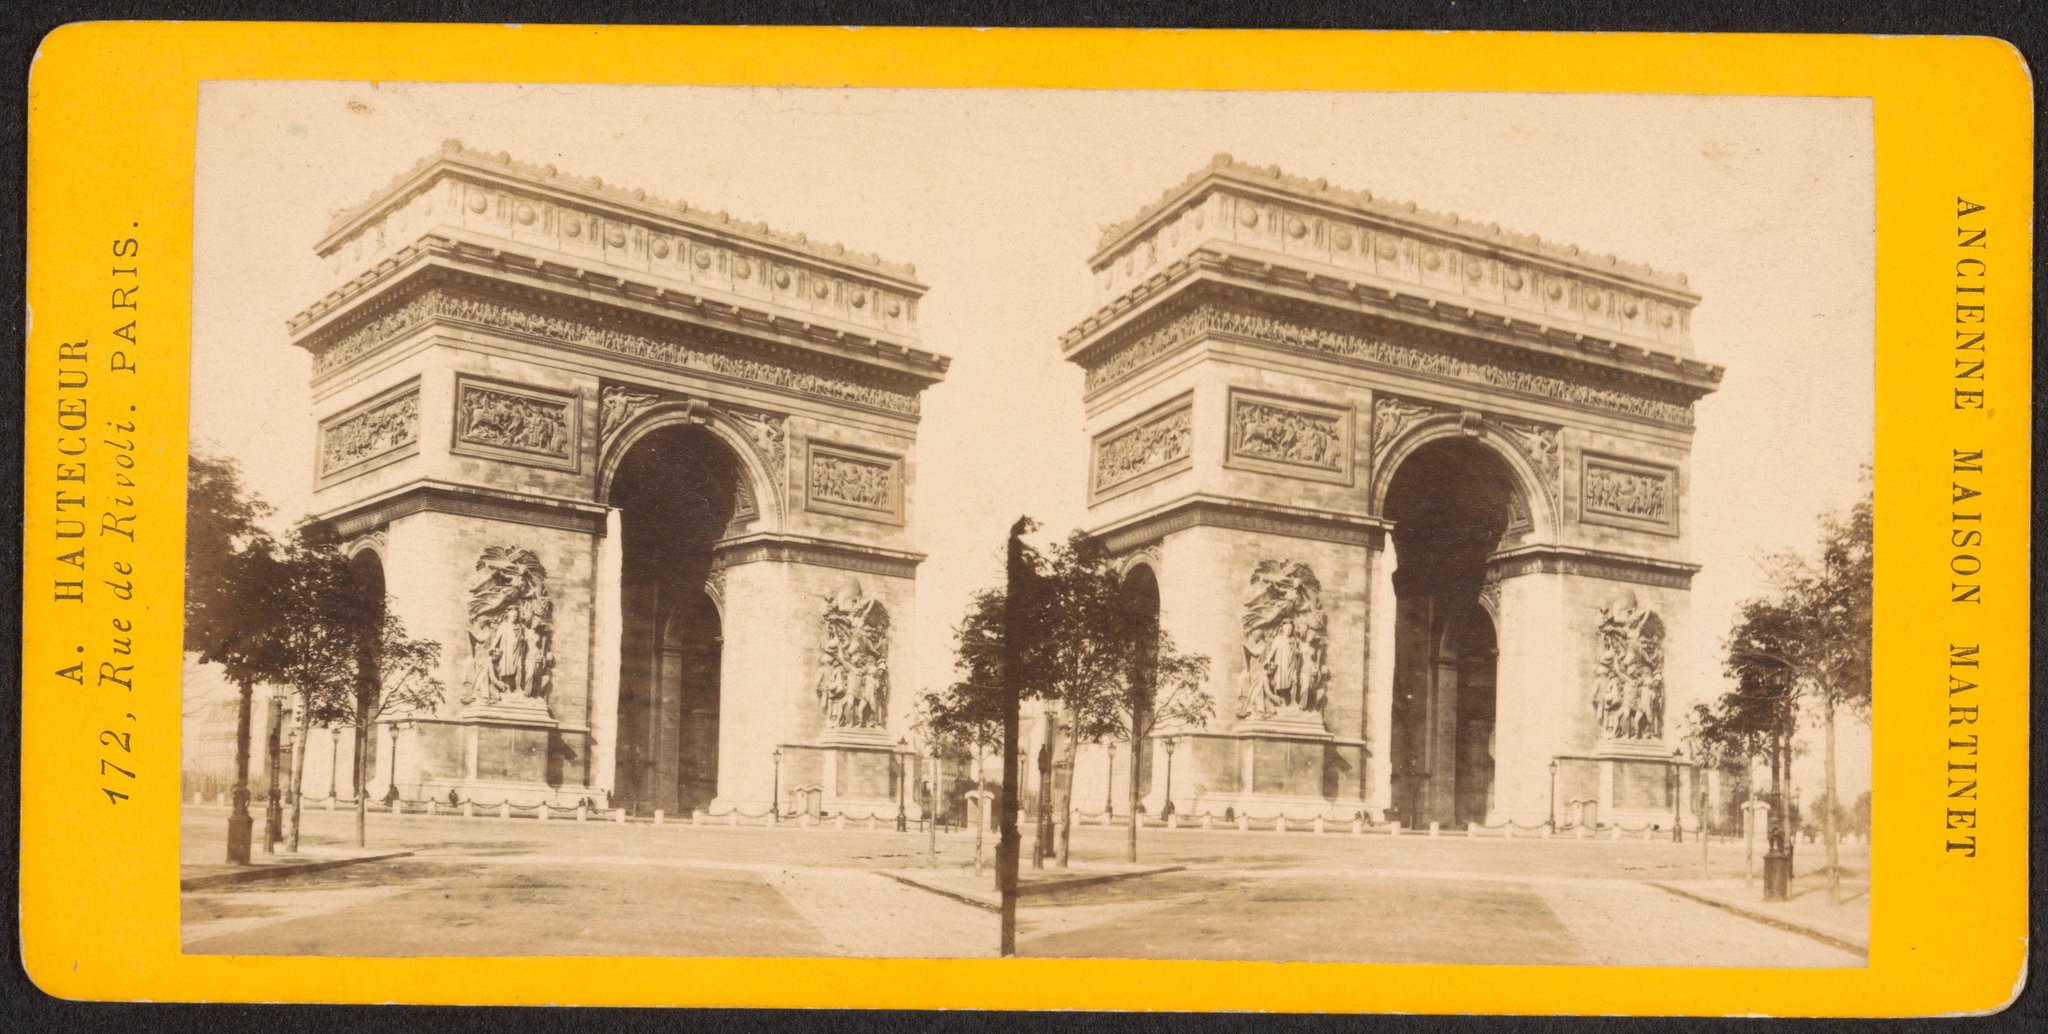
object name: stereograph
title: Gezicht op de Arc de Triomphe in Parijs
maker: albert hautecoeur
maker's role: publisher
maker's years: 1849-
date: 1860-1870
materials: cardboard, photographic support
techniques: albumen print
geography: paris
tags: triumphal arch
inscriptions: inscription: ‘Arc de l'Etoile’, name: ‘A. Hautecoeur 172, Rue de Rivoli. Paris Ancienne Maison Martinet’